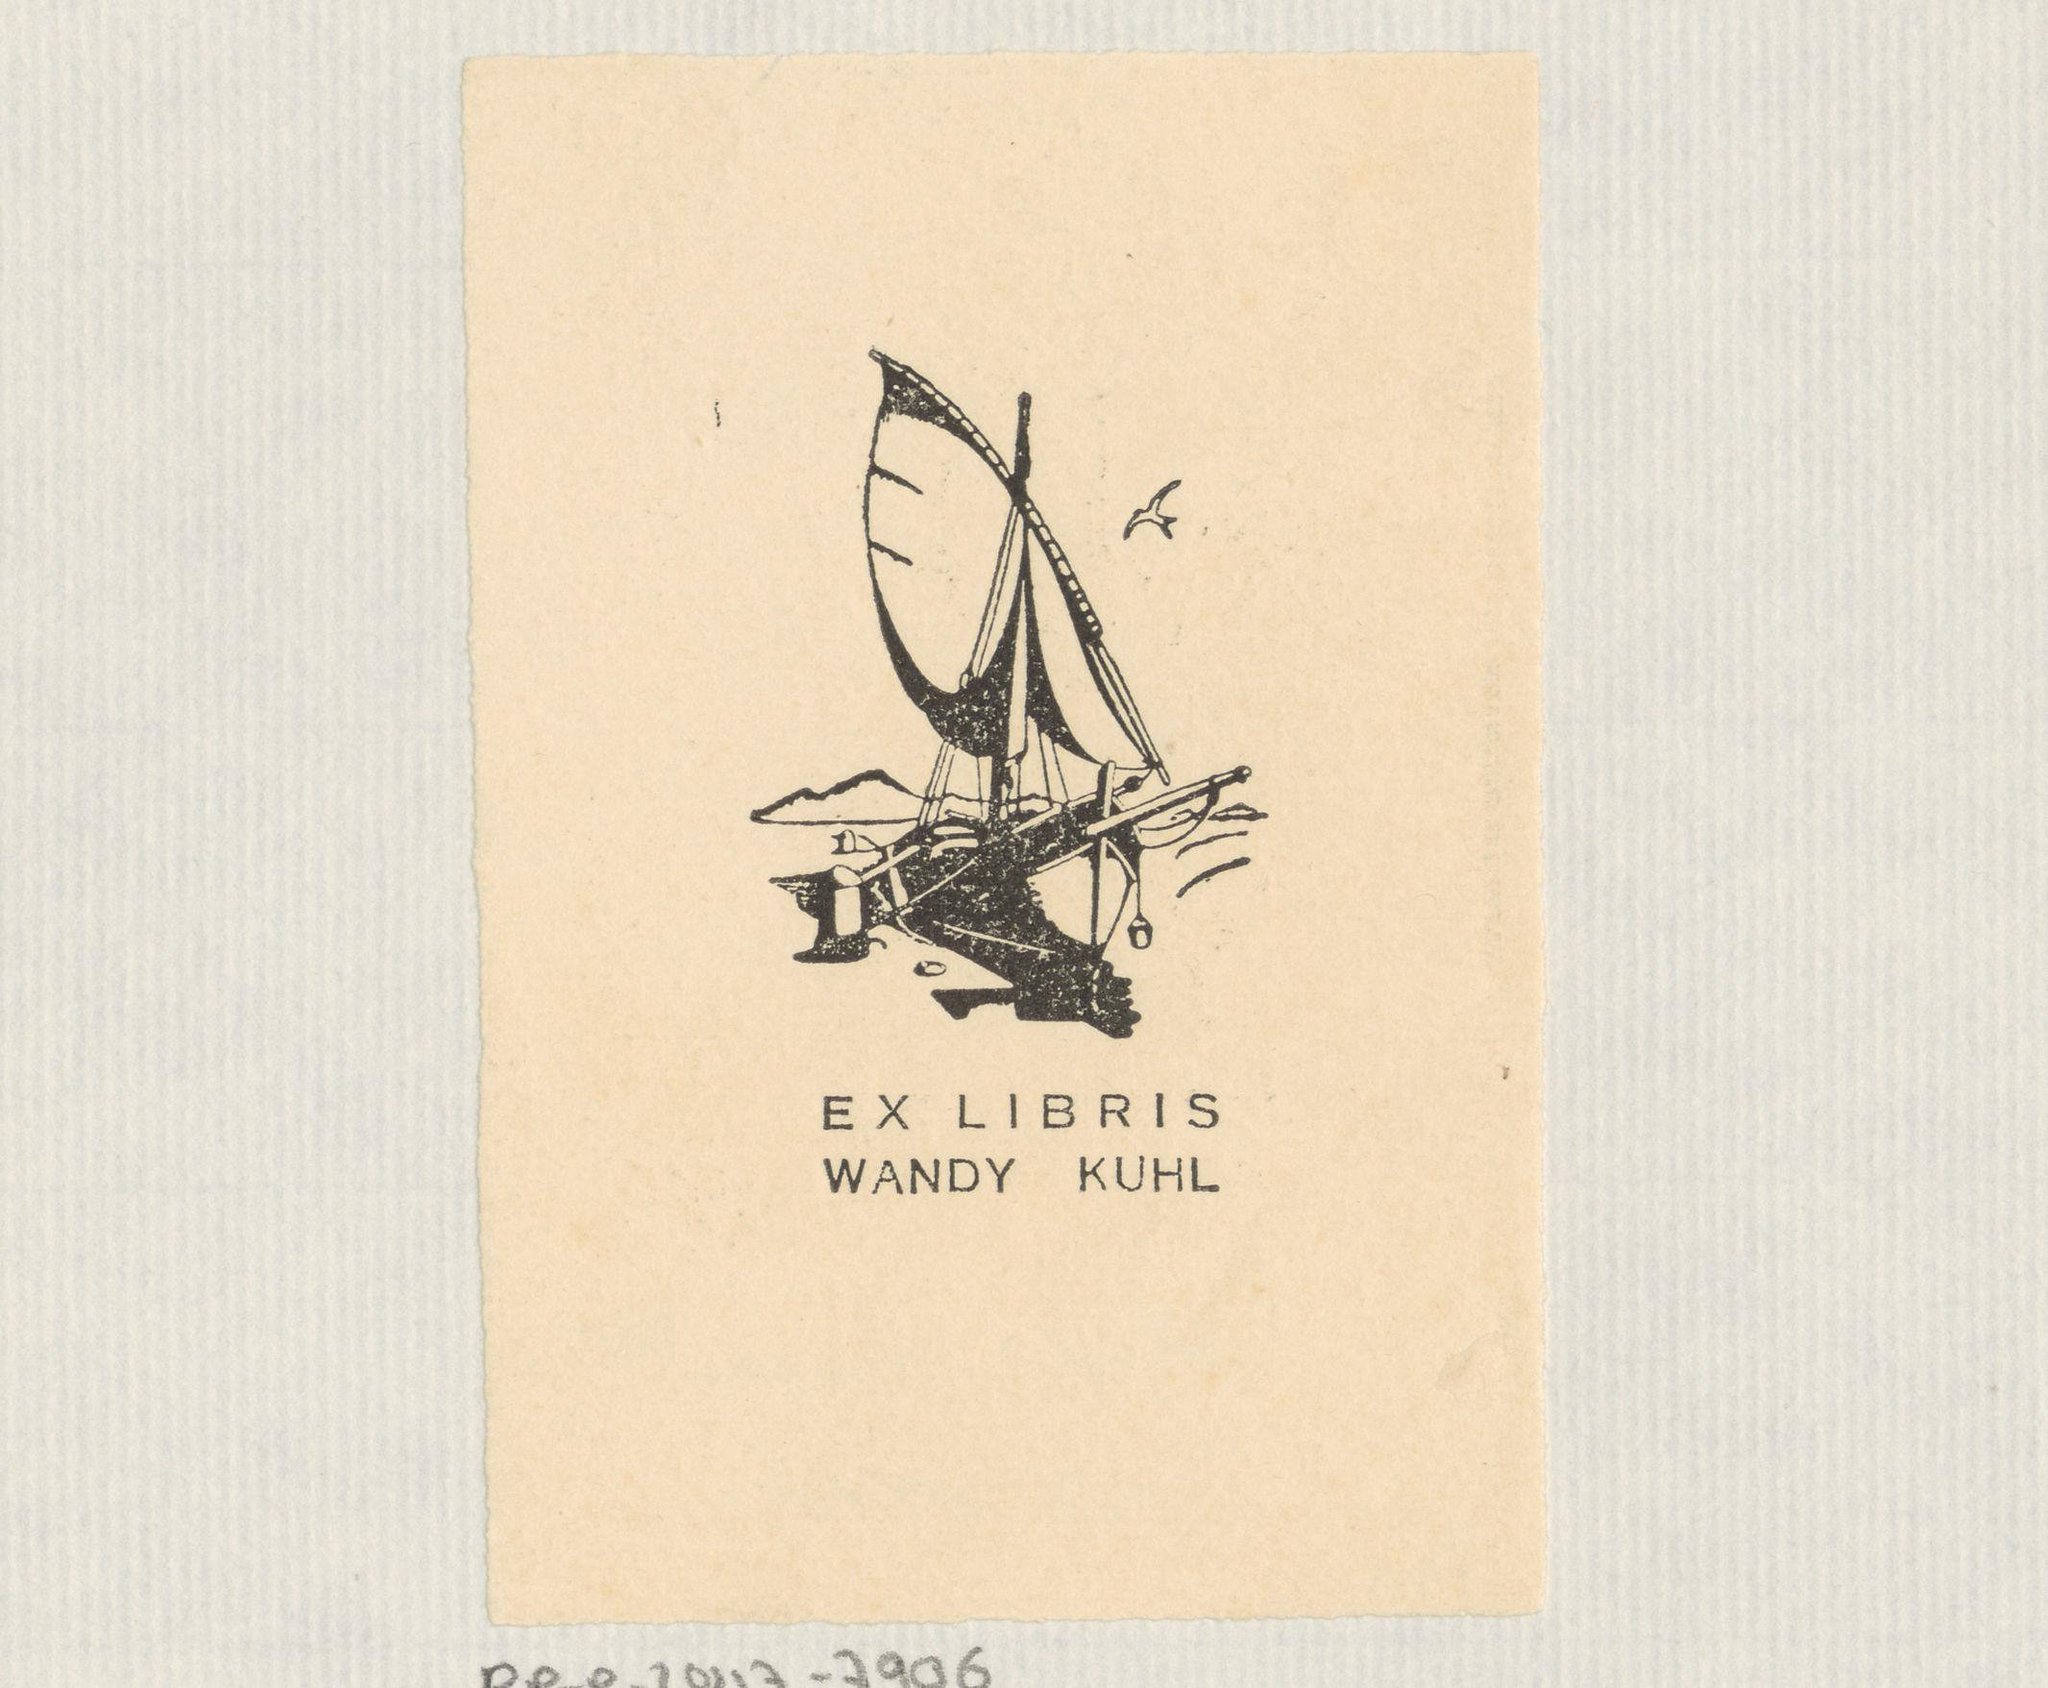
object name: bookplate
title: Ex libris van Wandy Kuhl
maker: Anonymous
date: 1900-1999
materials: paper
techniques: letterpress printing, printing block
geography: poland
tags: sailing-ship, sailing-boat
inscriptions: inscription: ‘Koperski [?]’